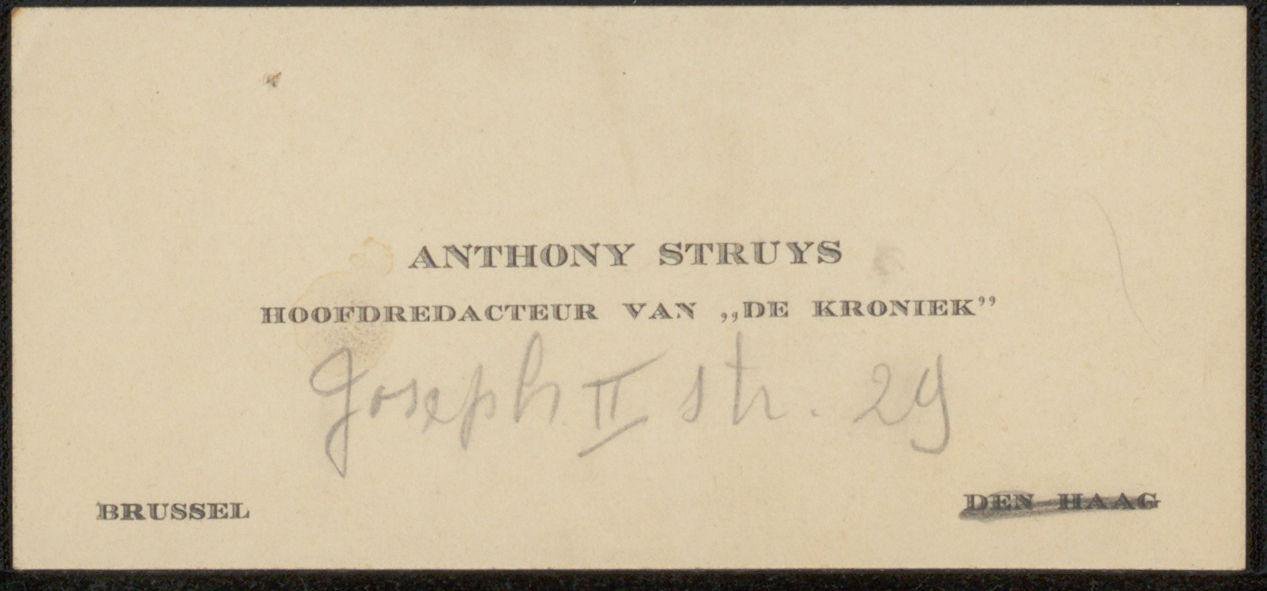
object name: visiting card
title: Visitekaartje aan Philip Zilcken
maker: anthony struys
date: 1867-1930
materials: cardboard, pencil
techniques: printing, writing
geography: brussels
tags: the hague, painter, draughtsman, philip zilcken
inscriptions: collector's mark: ‘RPK’